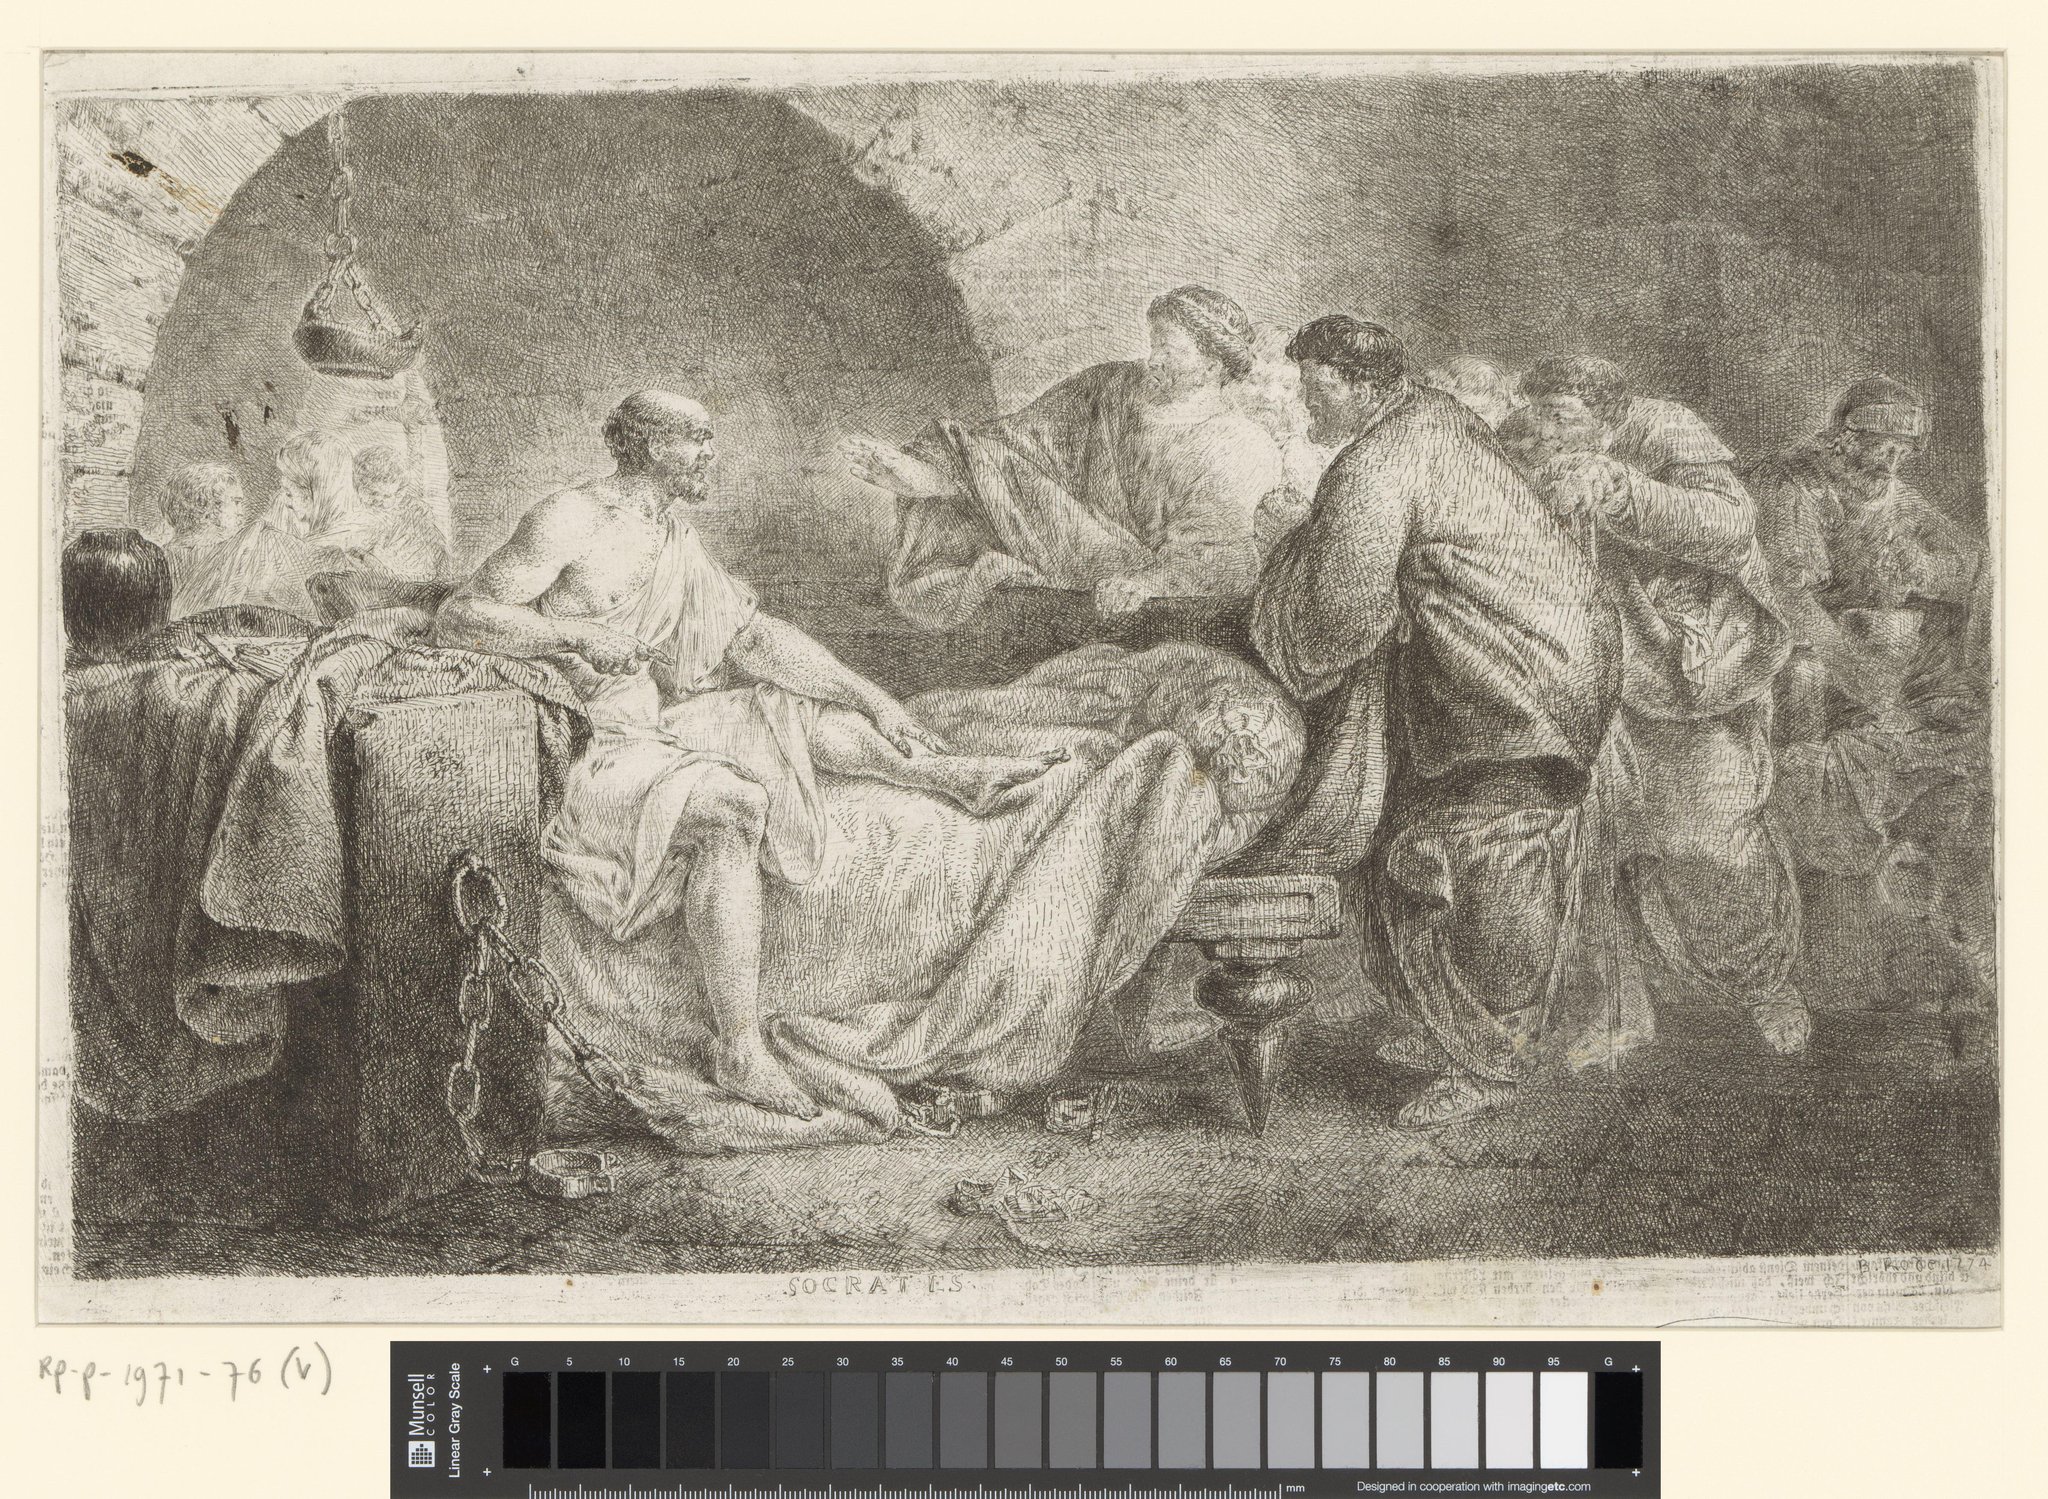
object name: print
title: Socrates neemt afscheid van zijn vrienden in de gevangenis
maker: bernhard rode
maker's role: artist, print maker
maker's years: 1725-1797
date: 1780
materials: paper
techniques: etching, letterpress printing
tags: death of socrates: in prison, surrounded by his grieving disciples, he calmly drinks the cup of poison after having made a libation to the gods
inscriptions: collector's mark: Lugt 2228, collector's mark: Lugt 2760